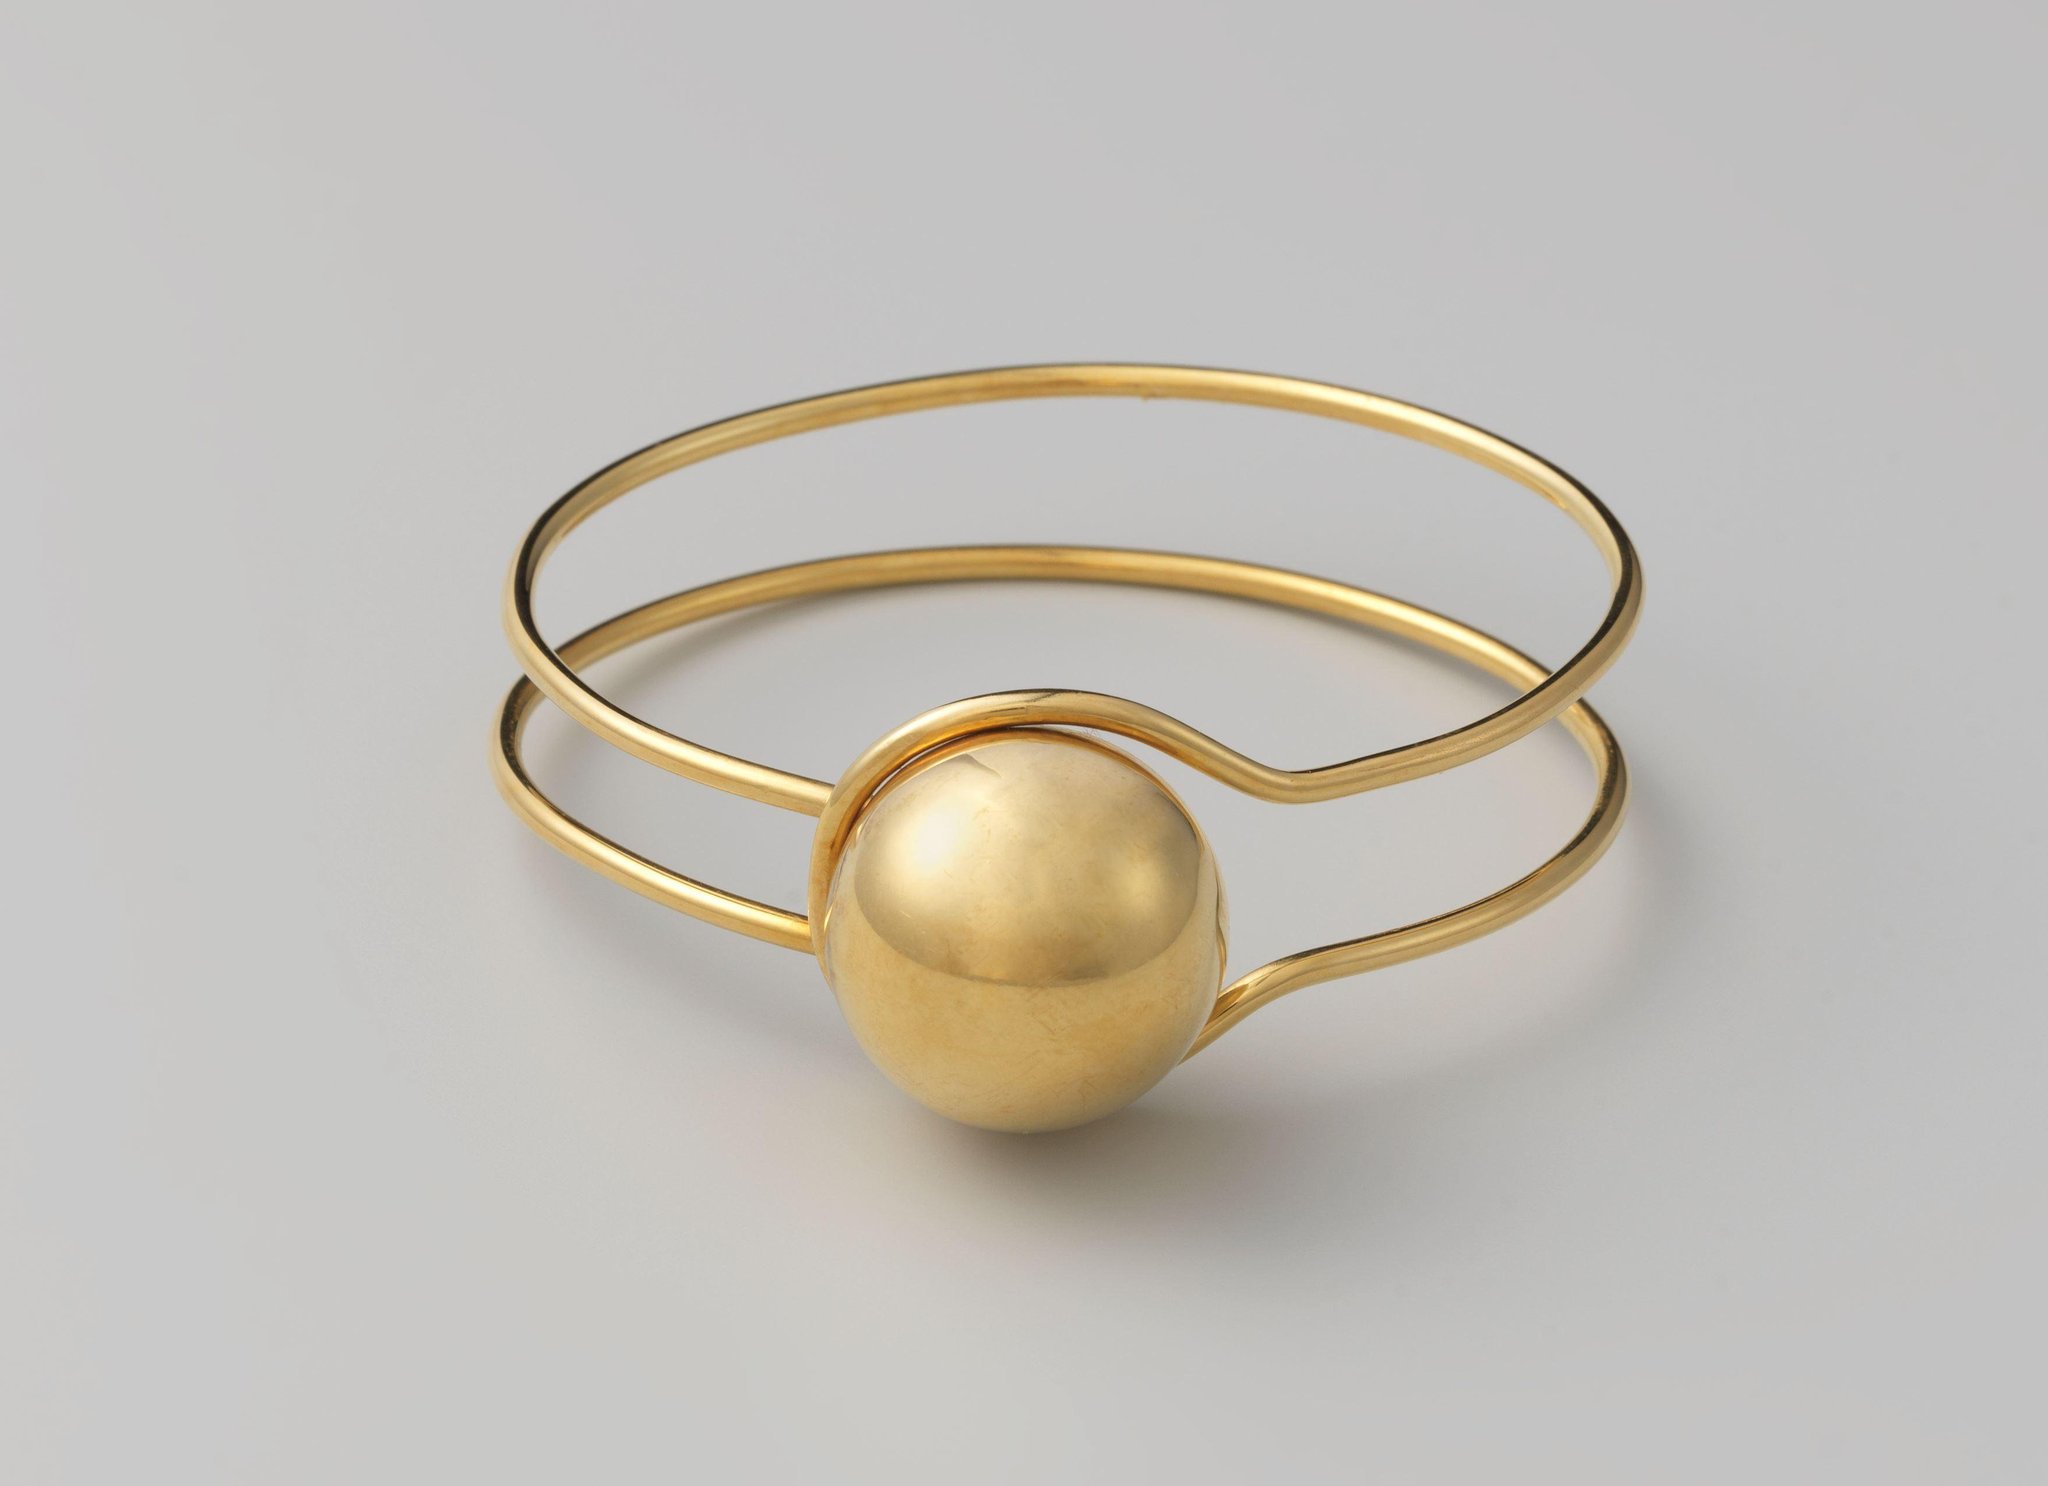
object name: bracelet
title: Armband van een dubbele gouddraad en een poli bol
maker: jan hessing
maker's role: juwelier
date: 1970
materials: gold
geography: voorburg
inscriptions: maker's mark: ‘JH’, alloy mark: ‘eikenblad 585’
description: Armband van een dubbele gouddraad en een poli bol.